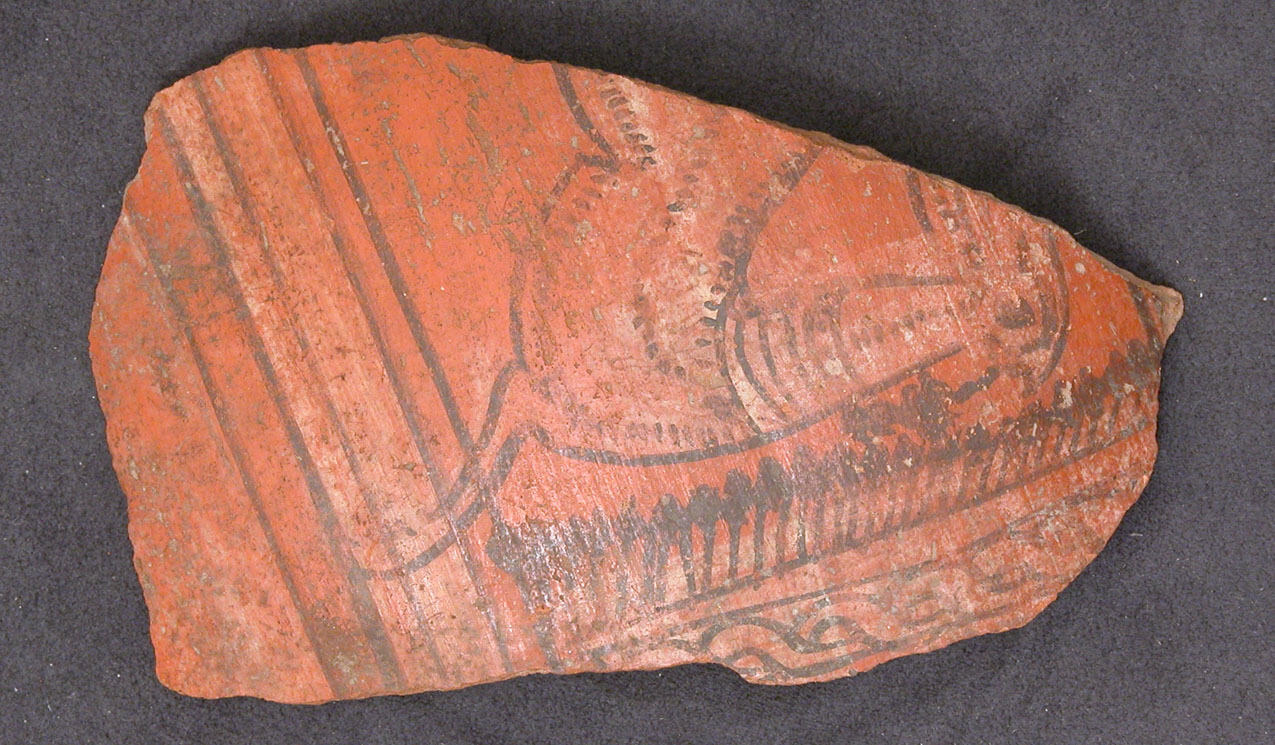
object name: fragment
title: Ceramic Fragment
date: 501-600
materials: earthenware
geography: egypt